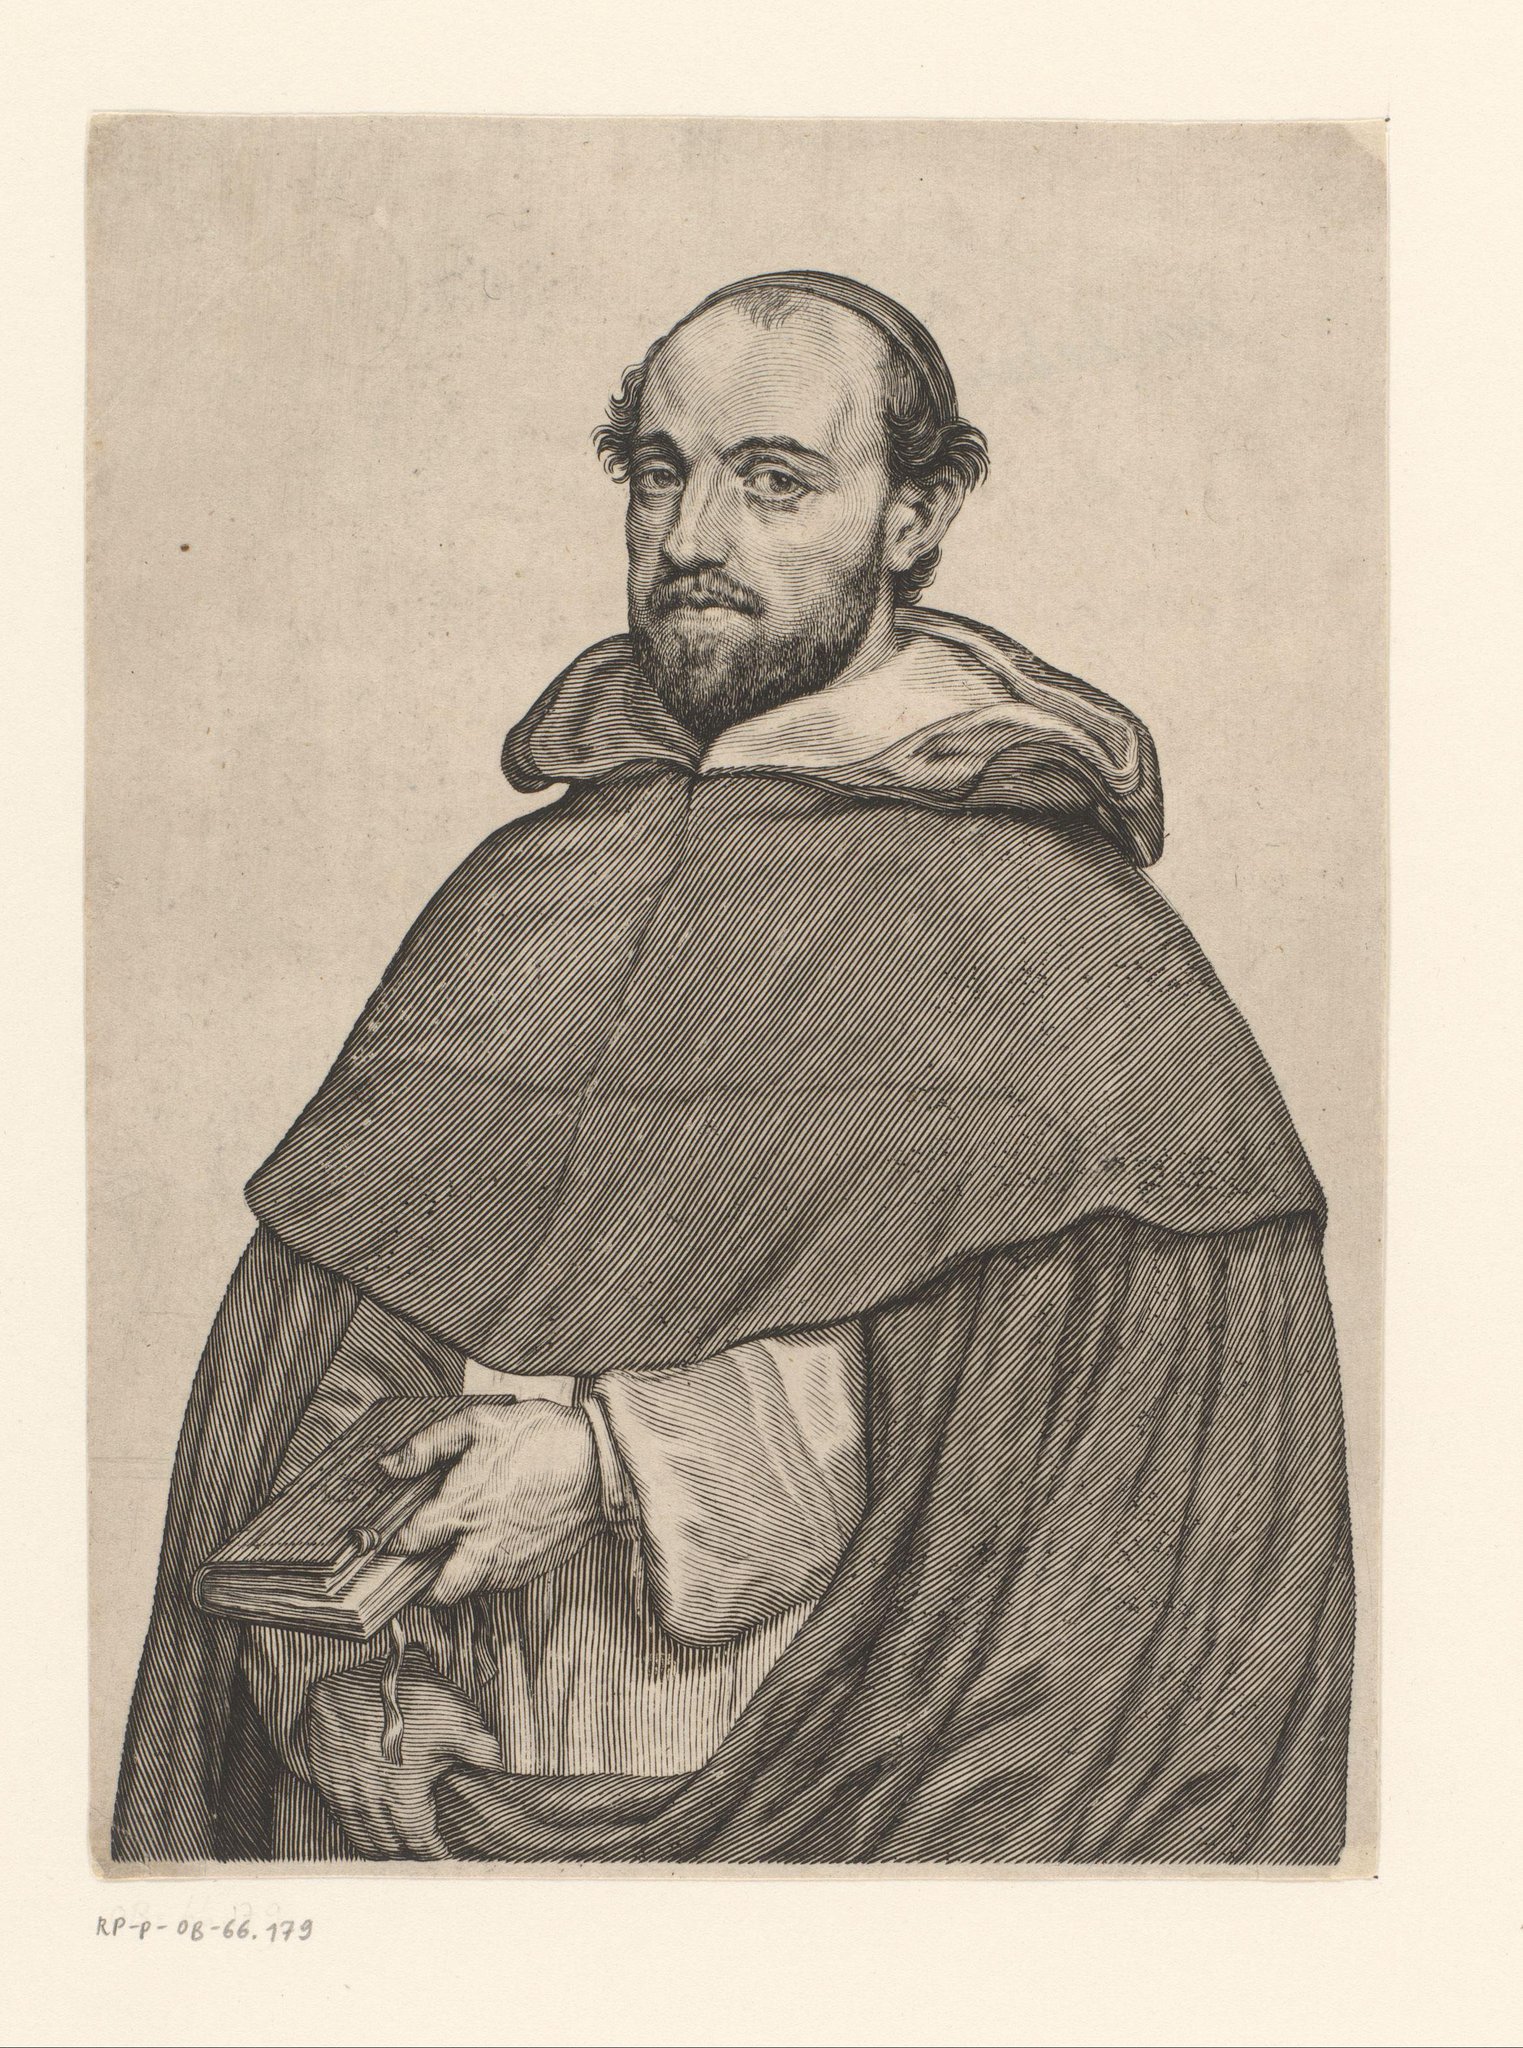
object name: print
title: Portret van prelaat met boek in de hand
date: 1600-1699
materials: paper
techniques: engraving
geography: france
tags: historical persons not known by name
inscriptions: collector's mark: Lugt 2228